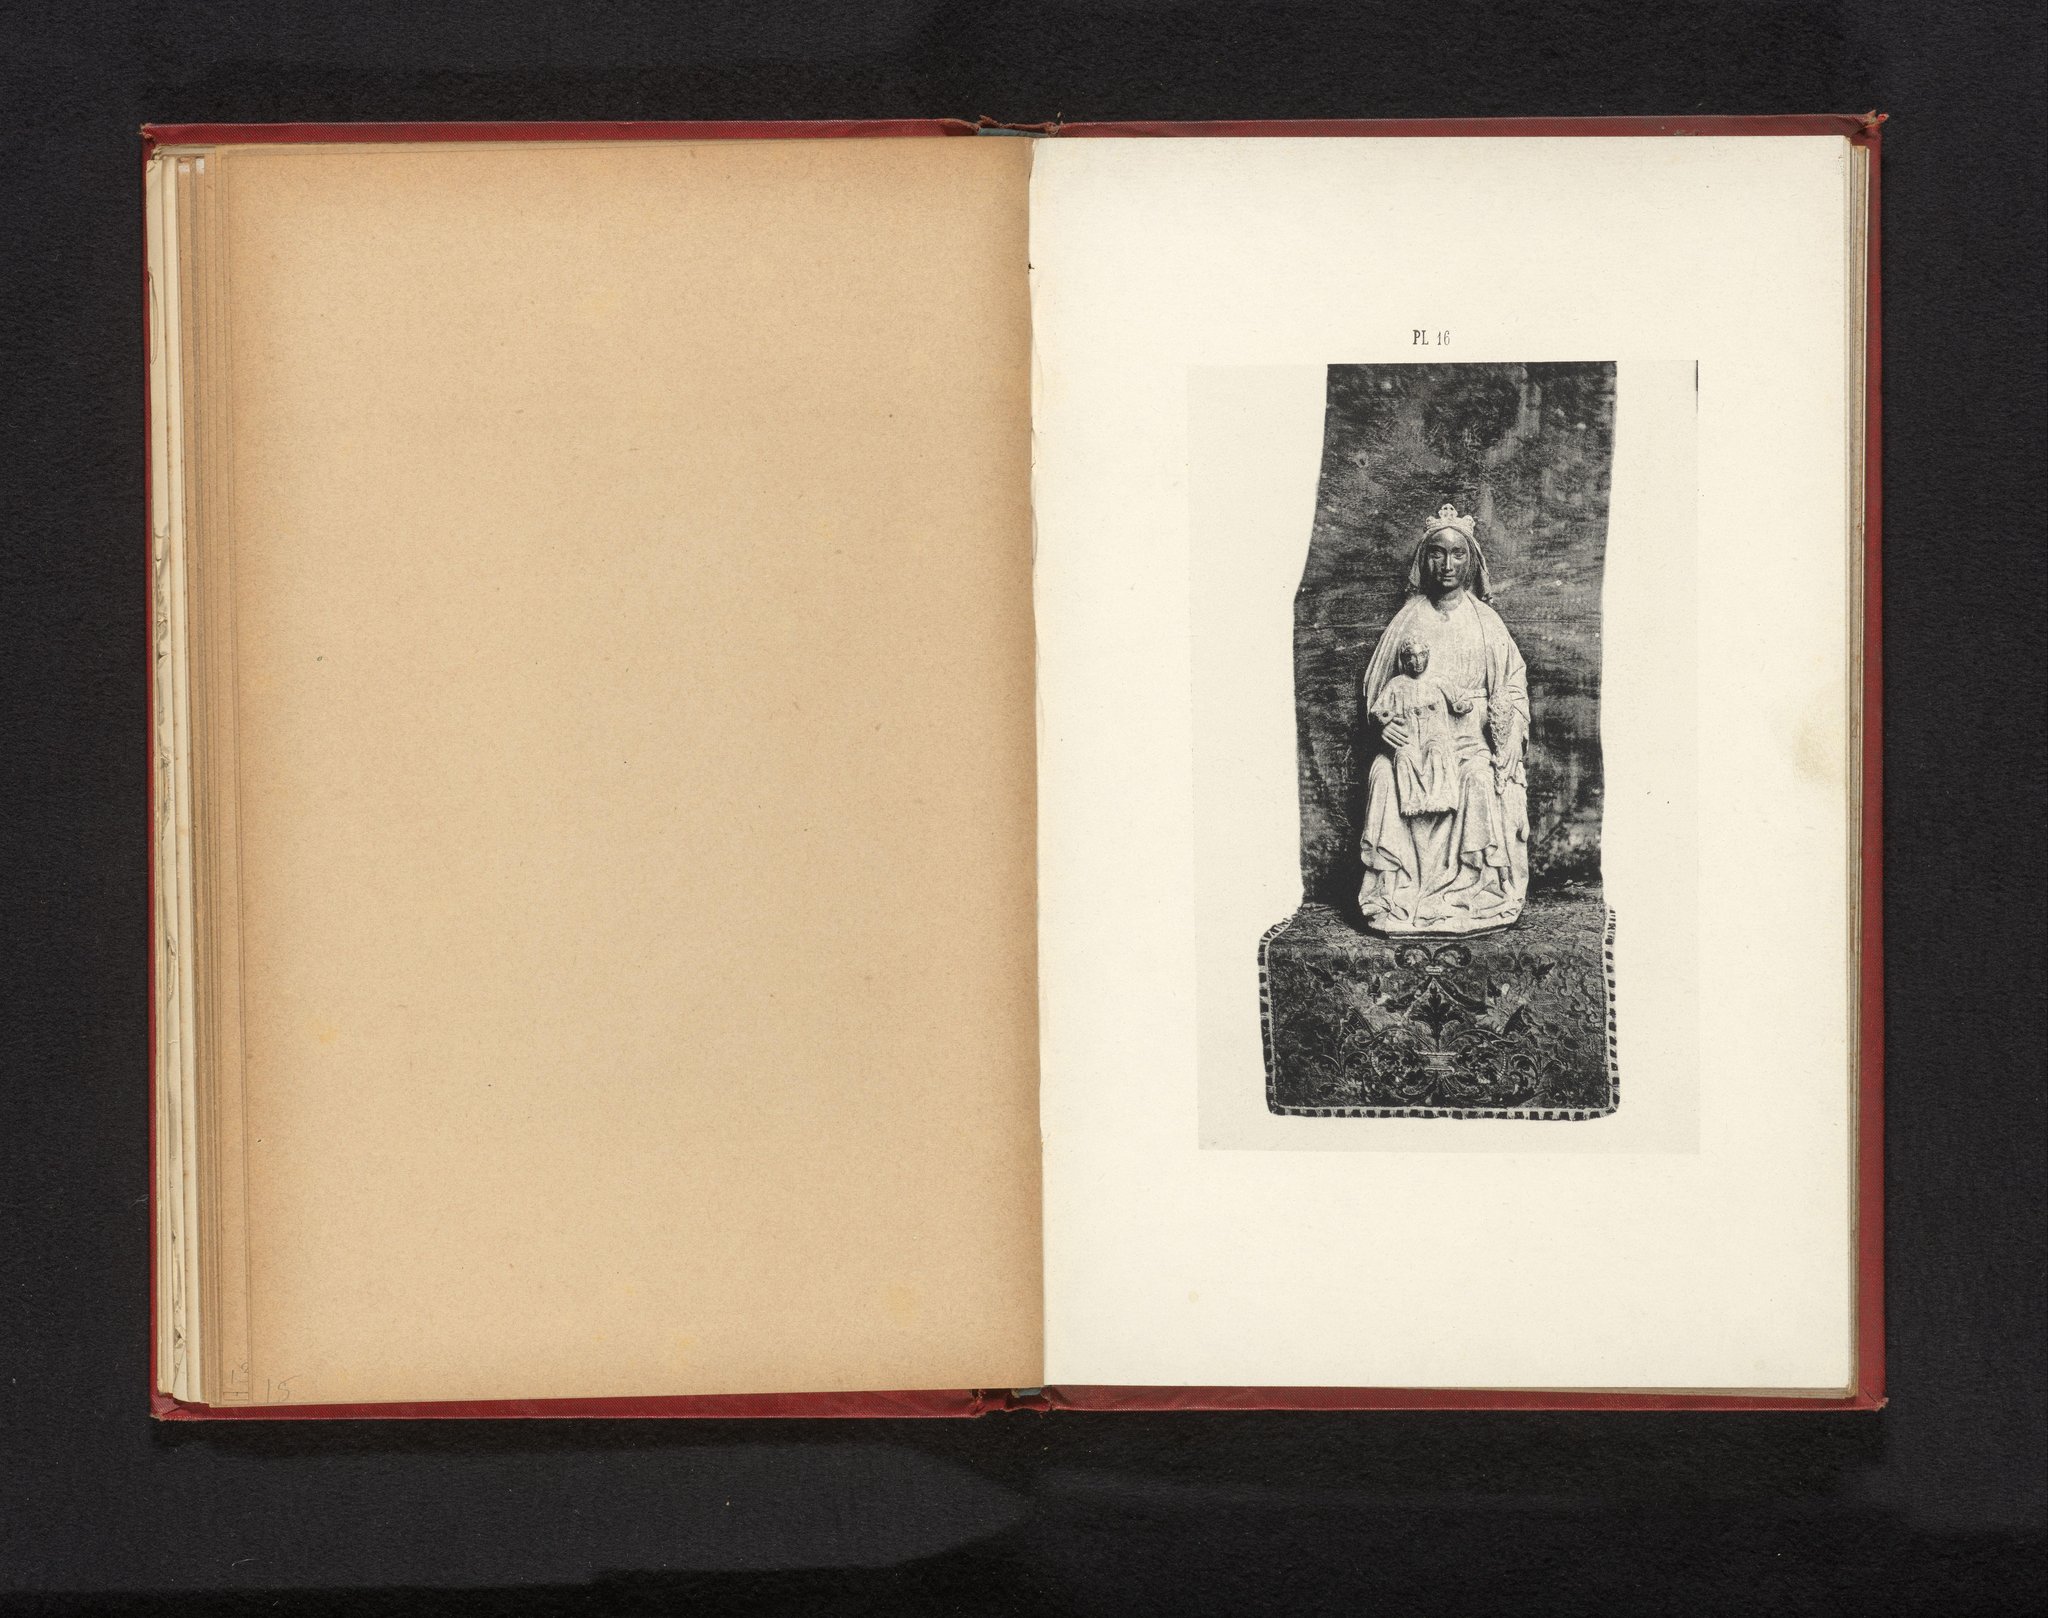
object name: page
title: Beeld van de Madonna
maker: Anonymous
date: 1880-1881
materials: paper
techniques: photograph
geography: barcelona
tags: madonna: i.e. mary with the christ-child, sculpture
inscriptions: number: ‘Pl 16’